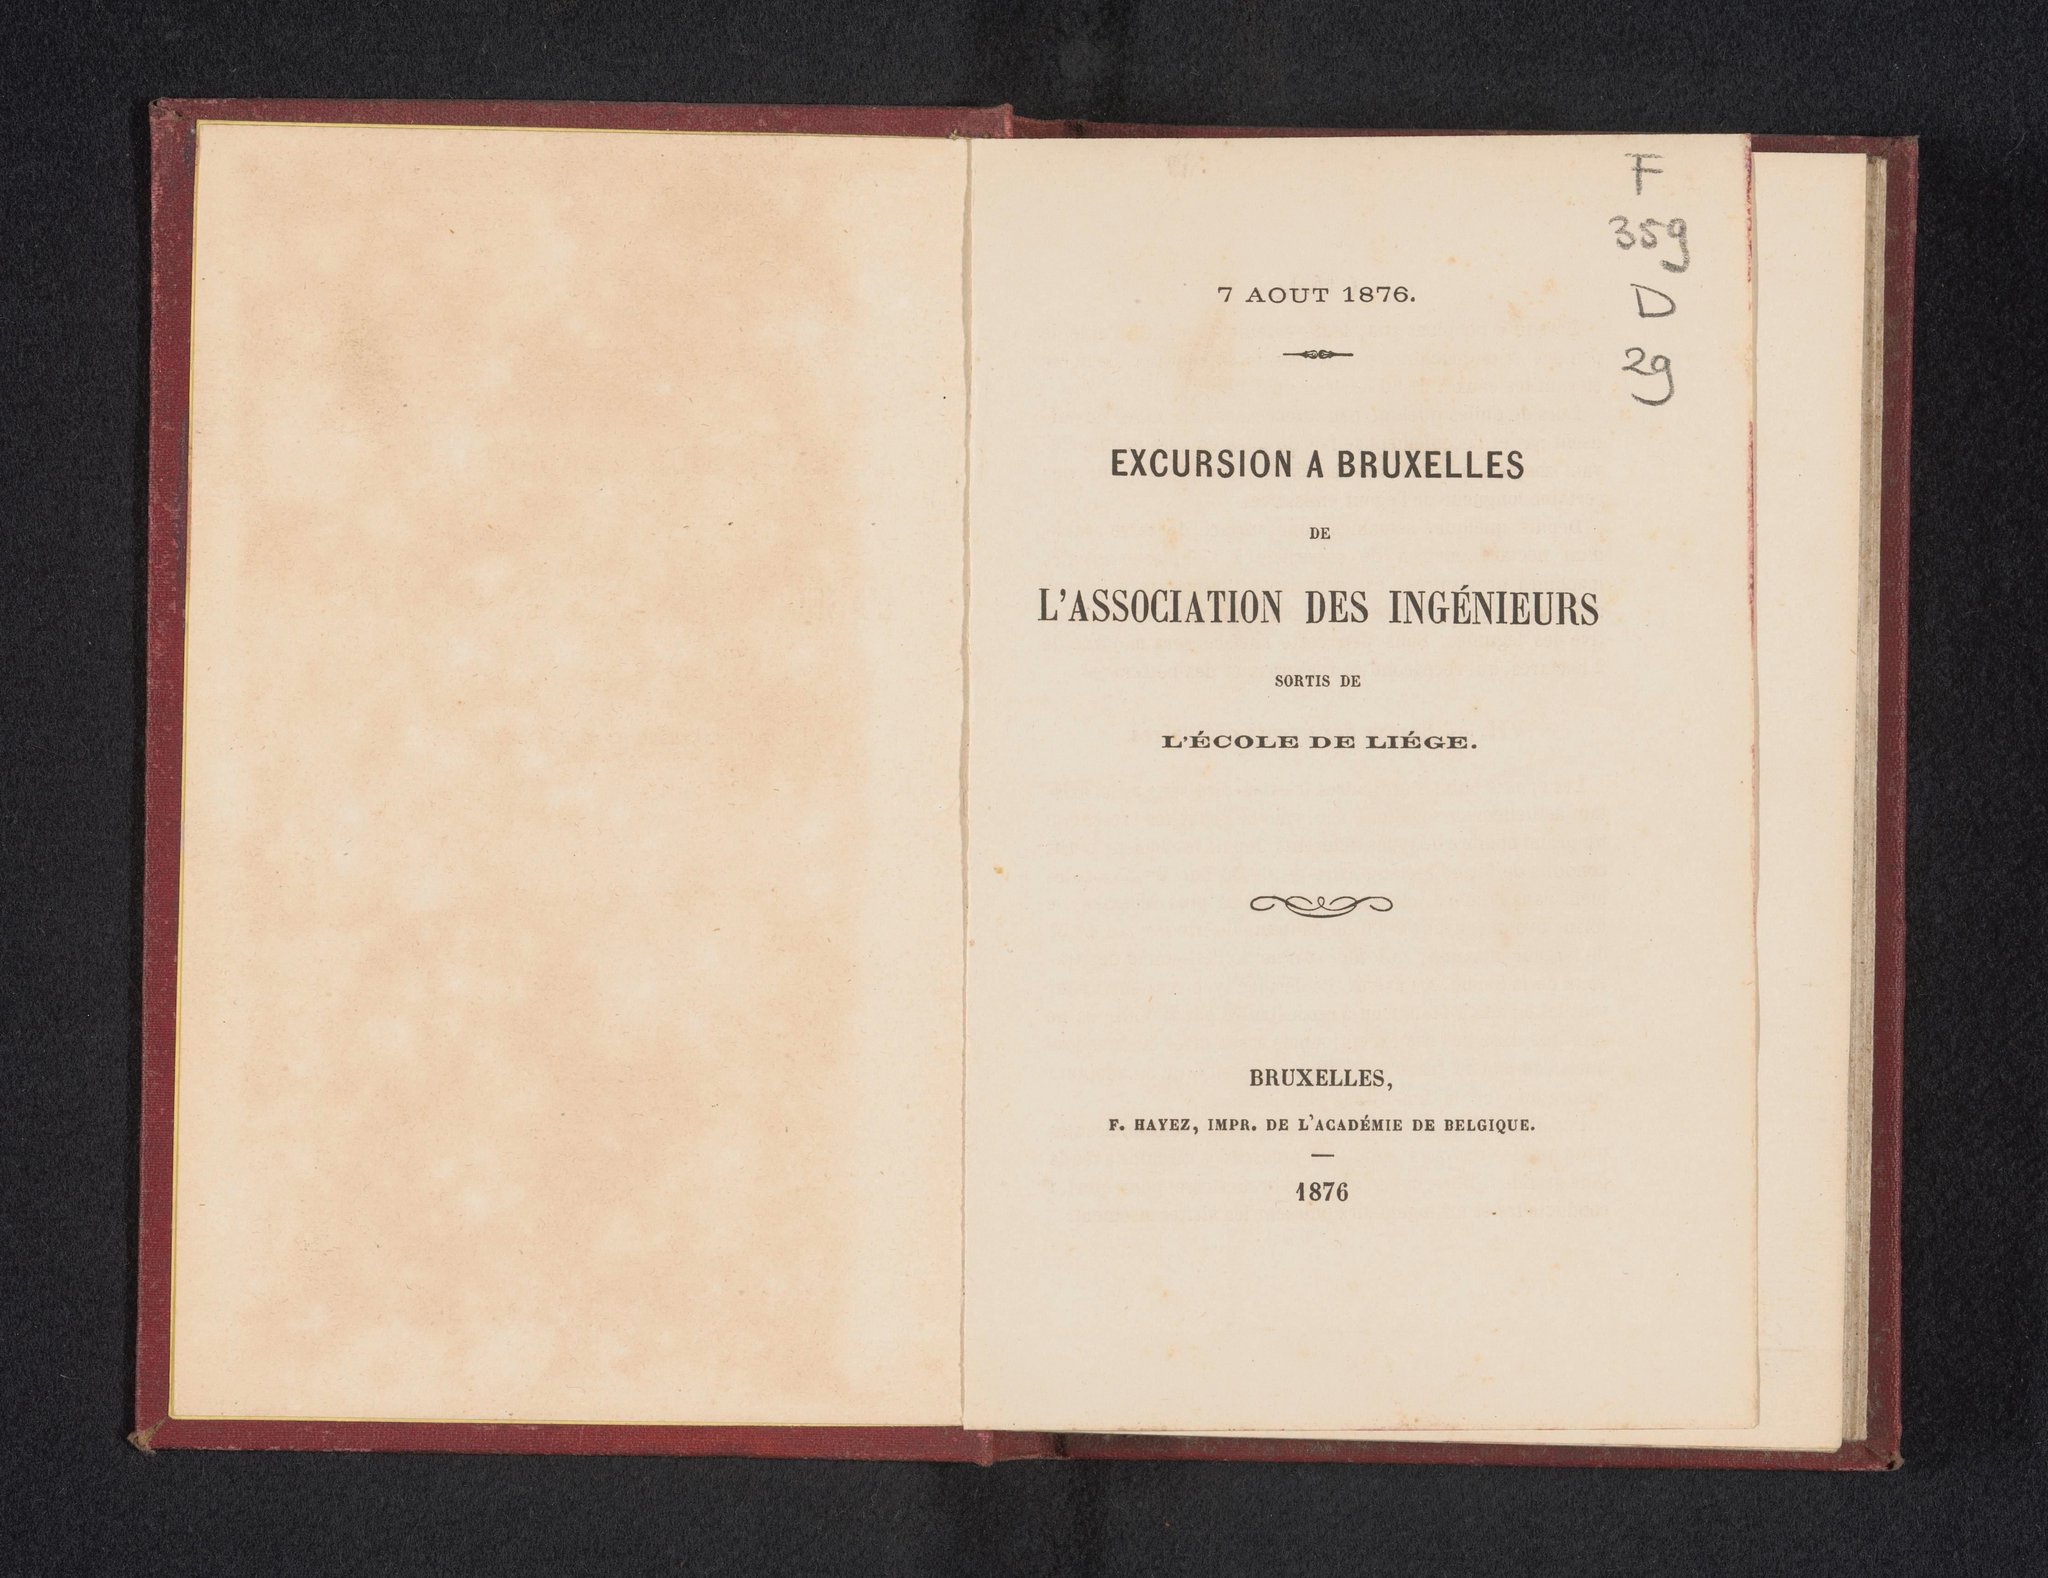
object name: book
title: Excursion à Bruxelles de l'Association des ingénieurs sortis de l'École de Liége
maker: f. hayez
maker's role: printer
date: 1876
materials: linen, paper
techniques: albumen print, photolithography, printing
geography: brussels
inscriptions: date: ‘Jun 1984’